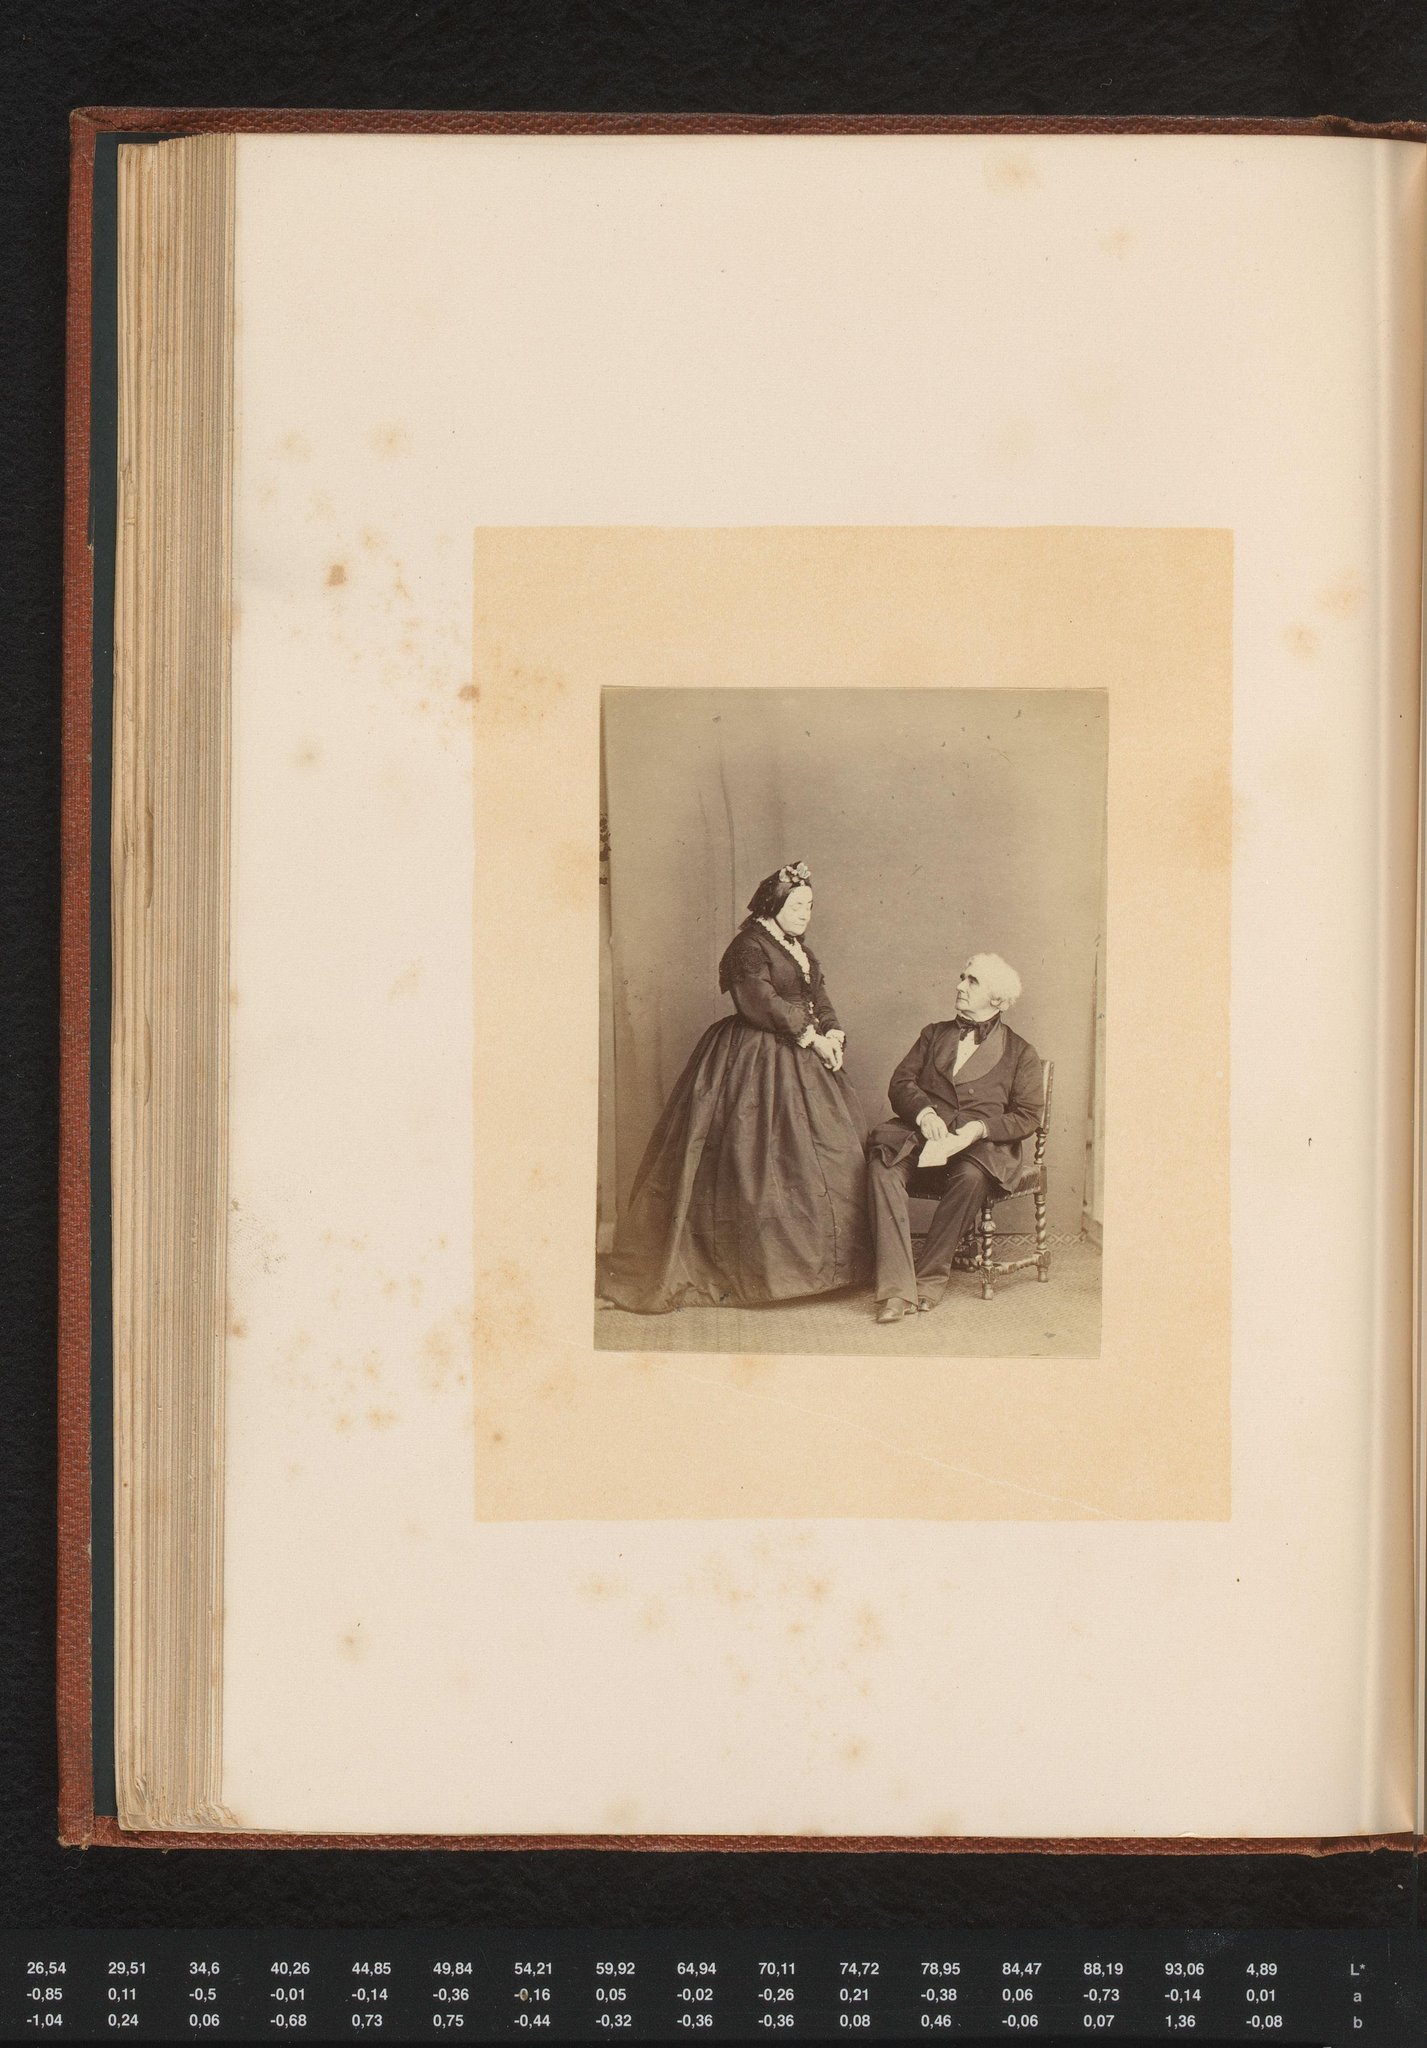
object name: page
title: Portret van Anna Maria en Samuel Carter Hall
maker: ernest edwards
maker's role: fotograaf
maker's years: 1837-1903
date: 1855-1866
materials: paper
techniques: albumen print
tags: samuel carter hall, anna maria hall, historical persons, marriage, married couple, 'matrimonium'